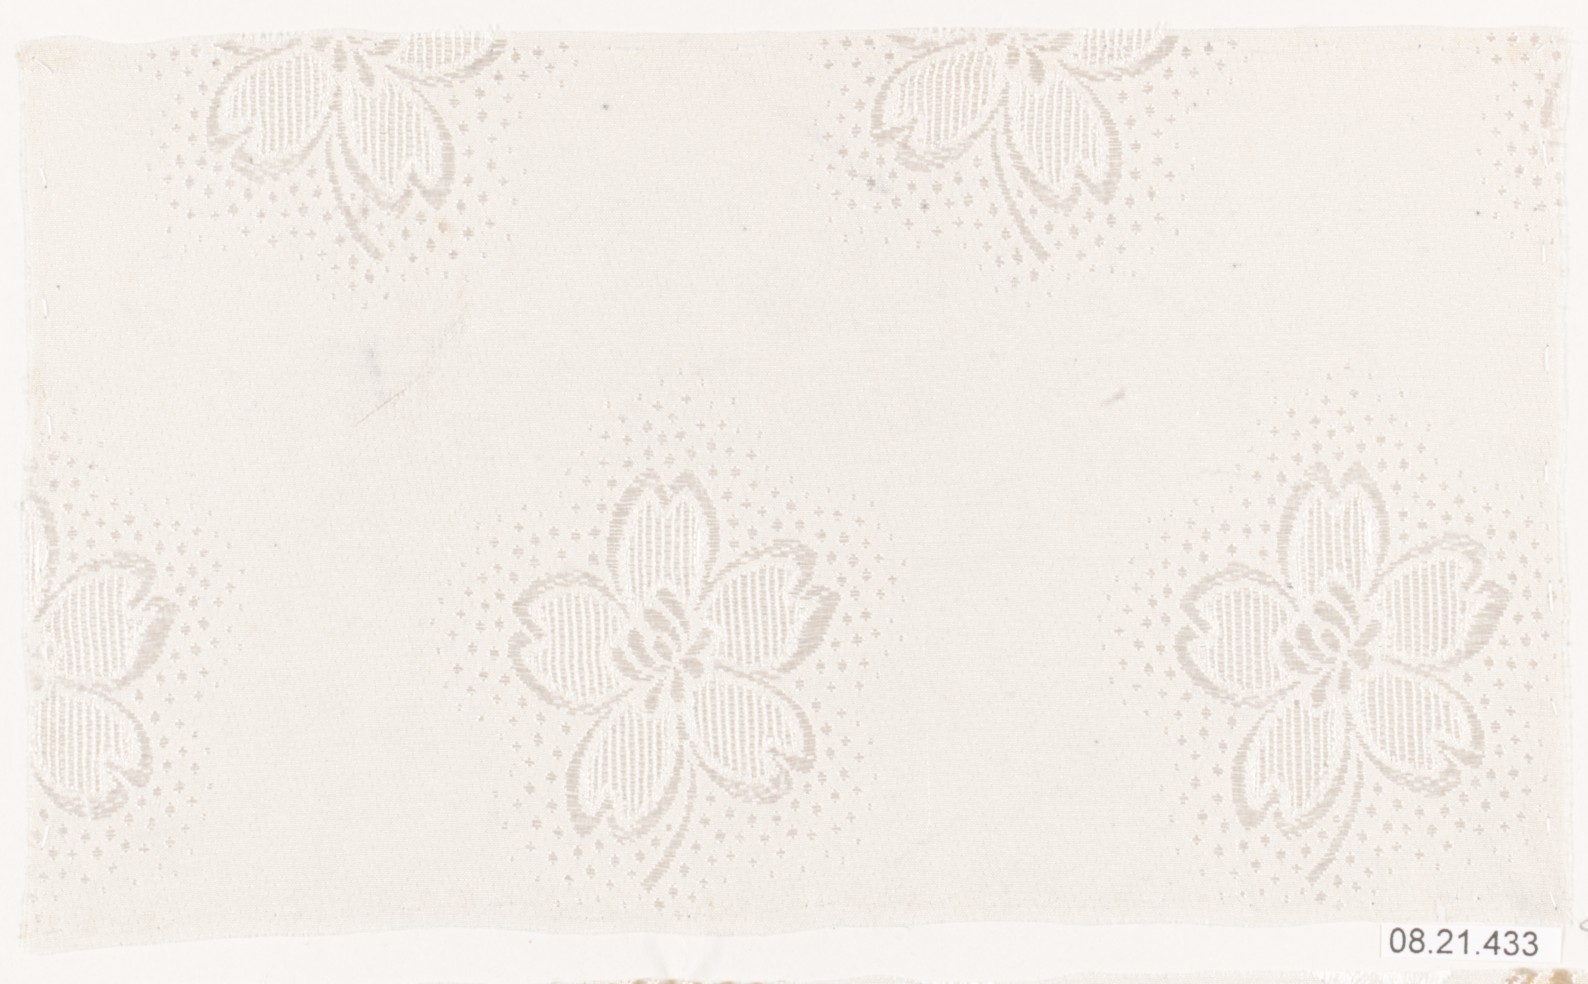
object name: textile sample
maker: Anonymous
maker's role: designer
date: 1900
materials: silk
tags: flowers